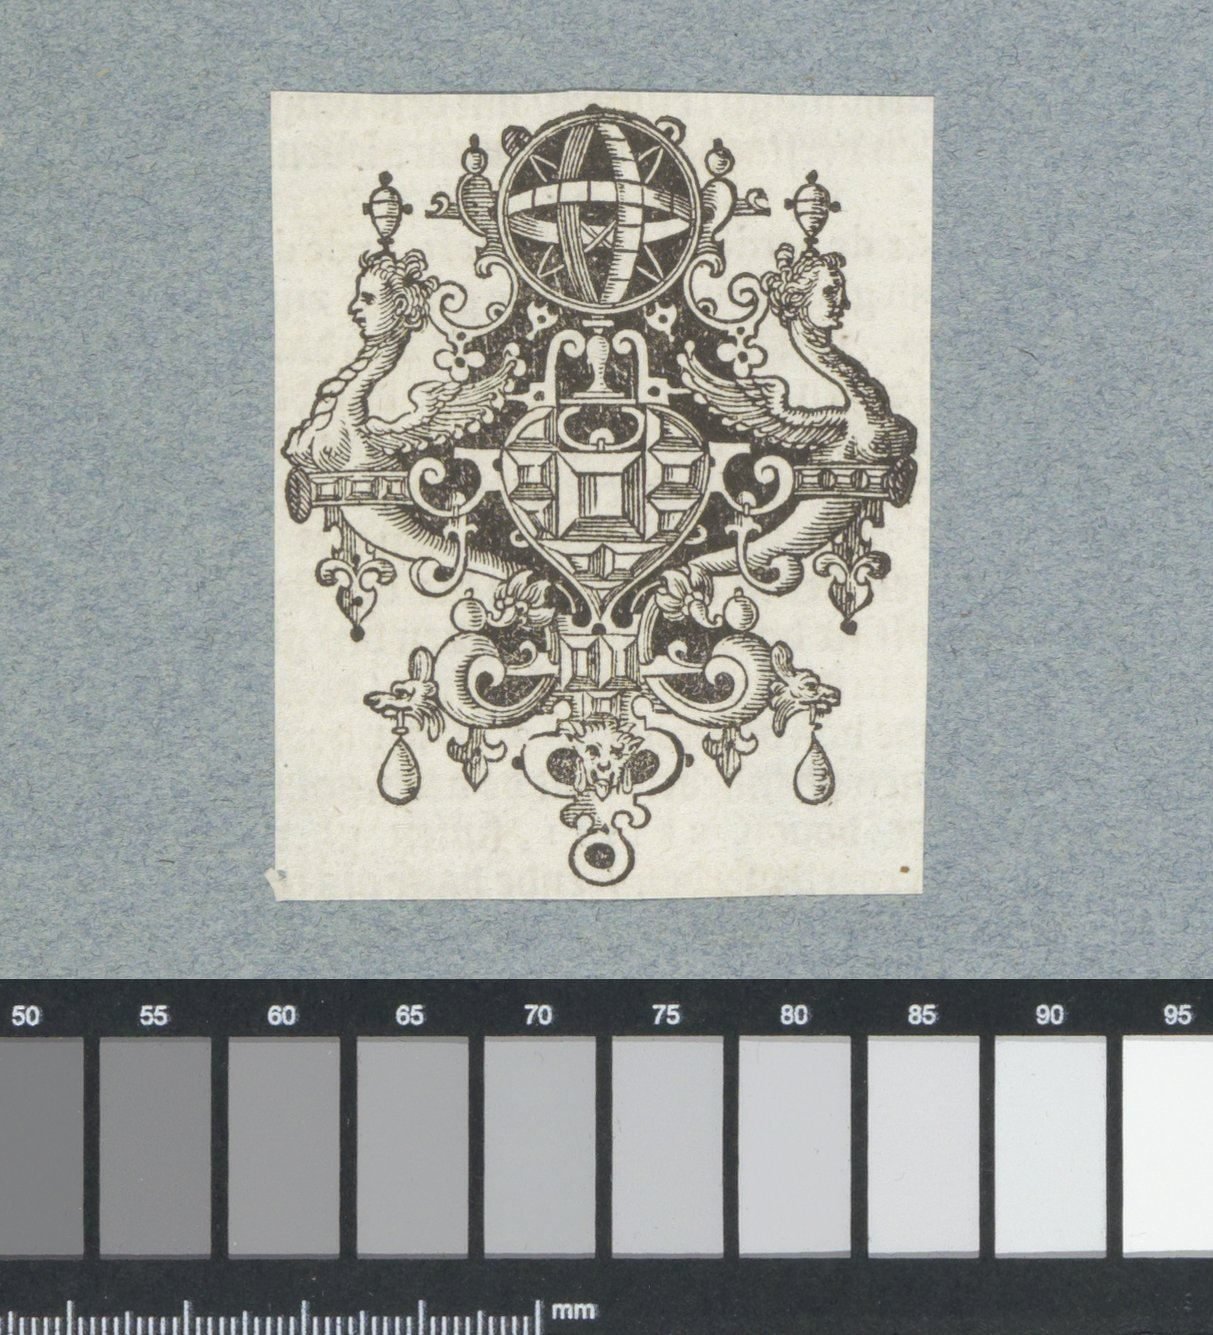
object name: print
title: Ornament met edelstenen en hemelglobe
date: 1597-1667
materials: paper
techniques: letterpress printing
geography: amsterdam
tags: ornamental decoration ~ printed matter, book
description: Afkomstig uit een van de uitgaven van P.J. Paets uit Amsterdam.